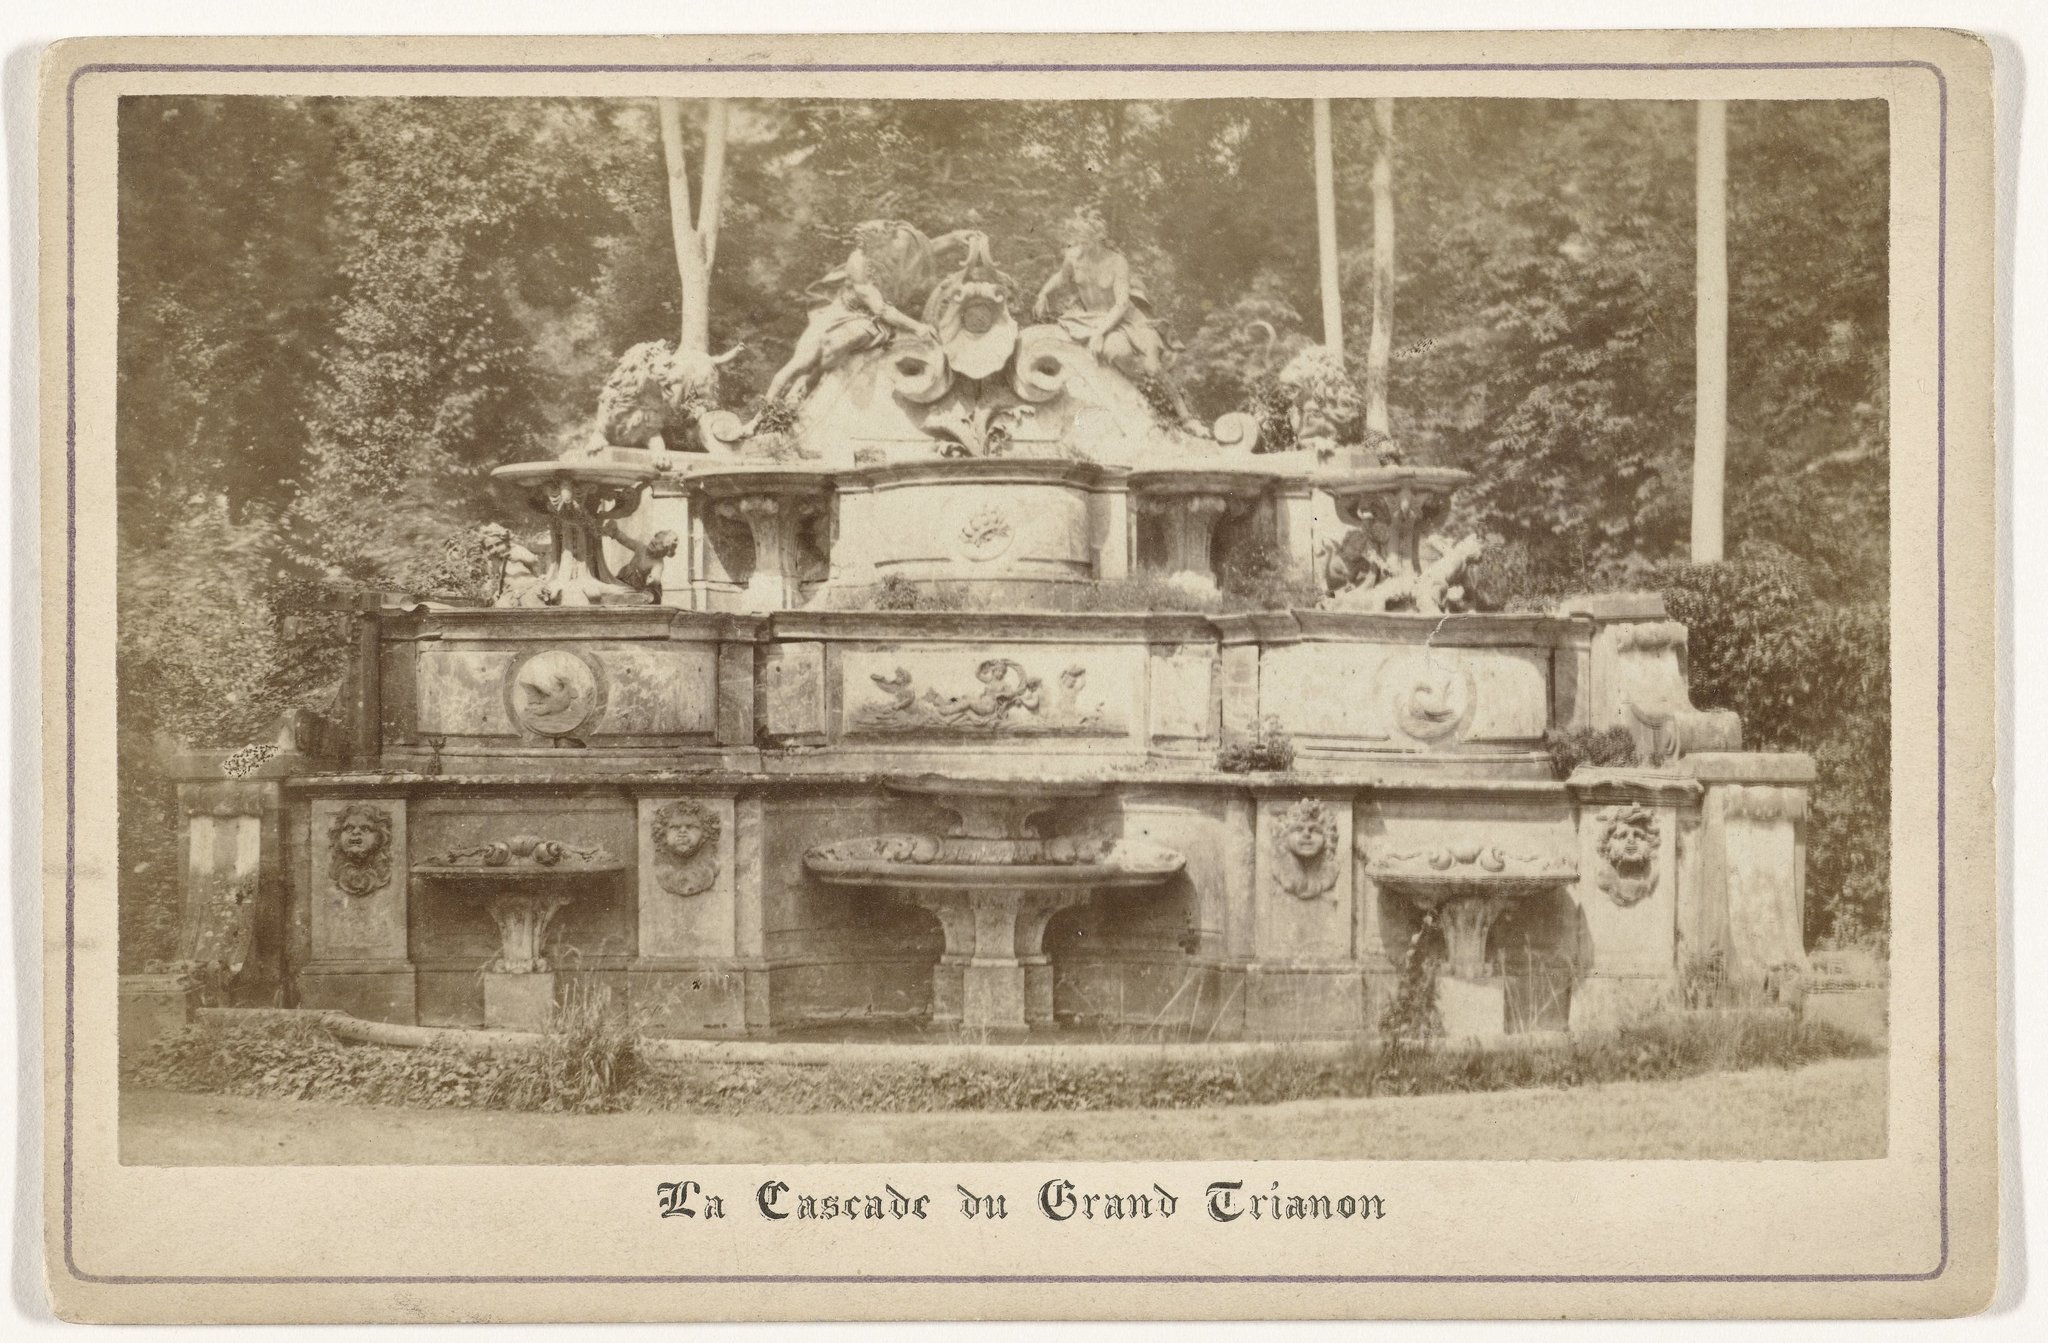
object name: cabinet photograph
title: La Cascade du Grand Trianon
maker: Anonymous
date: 1870-1900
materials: cardboard, paper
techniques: albumen print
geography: versailles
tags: garden fountain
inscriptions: title: ‘La Cascade du Grand Trianon’, inscription: ‘uit top Frk. 2003’